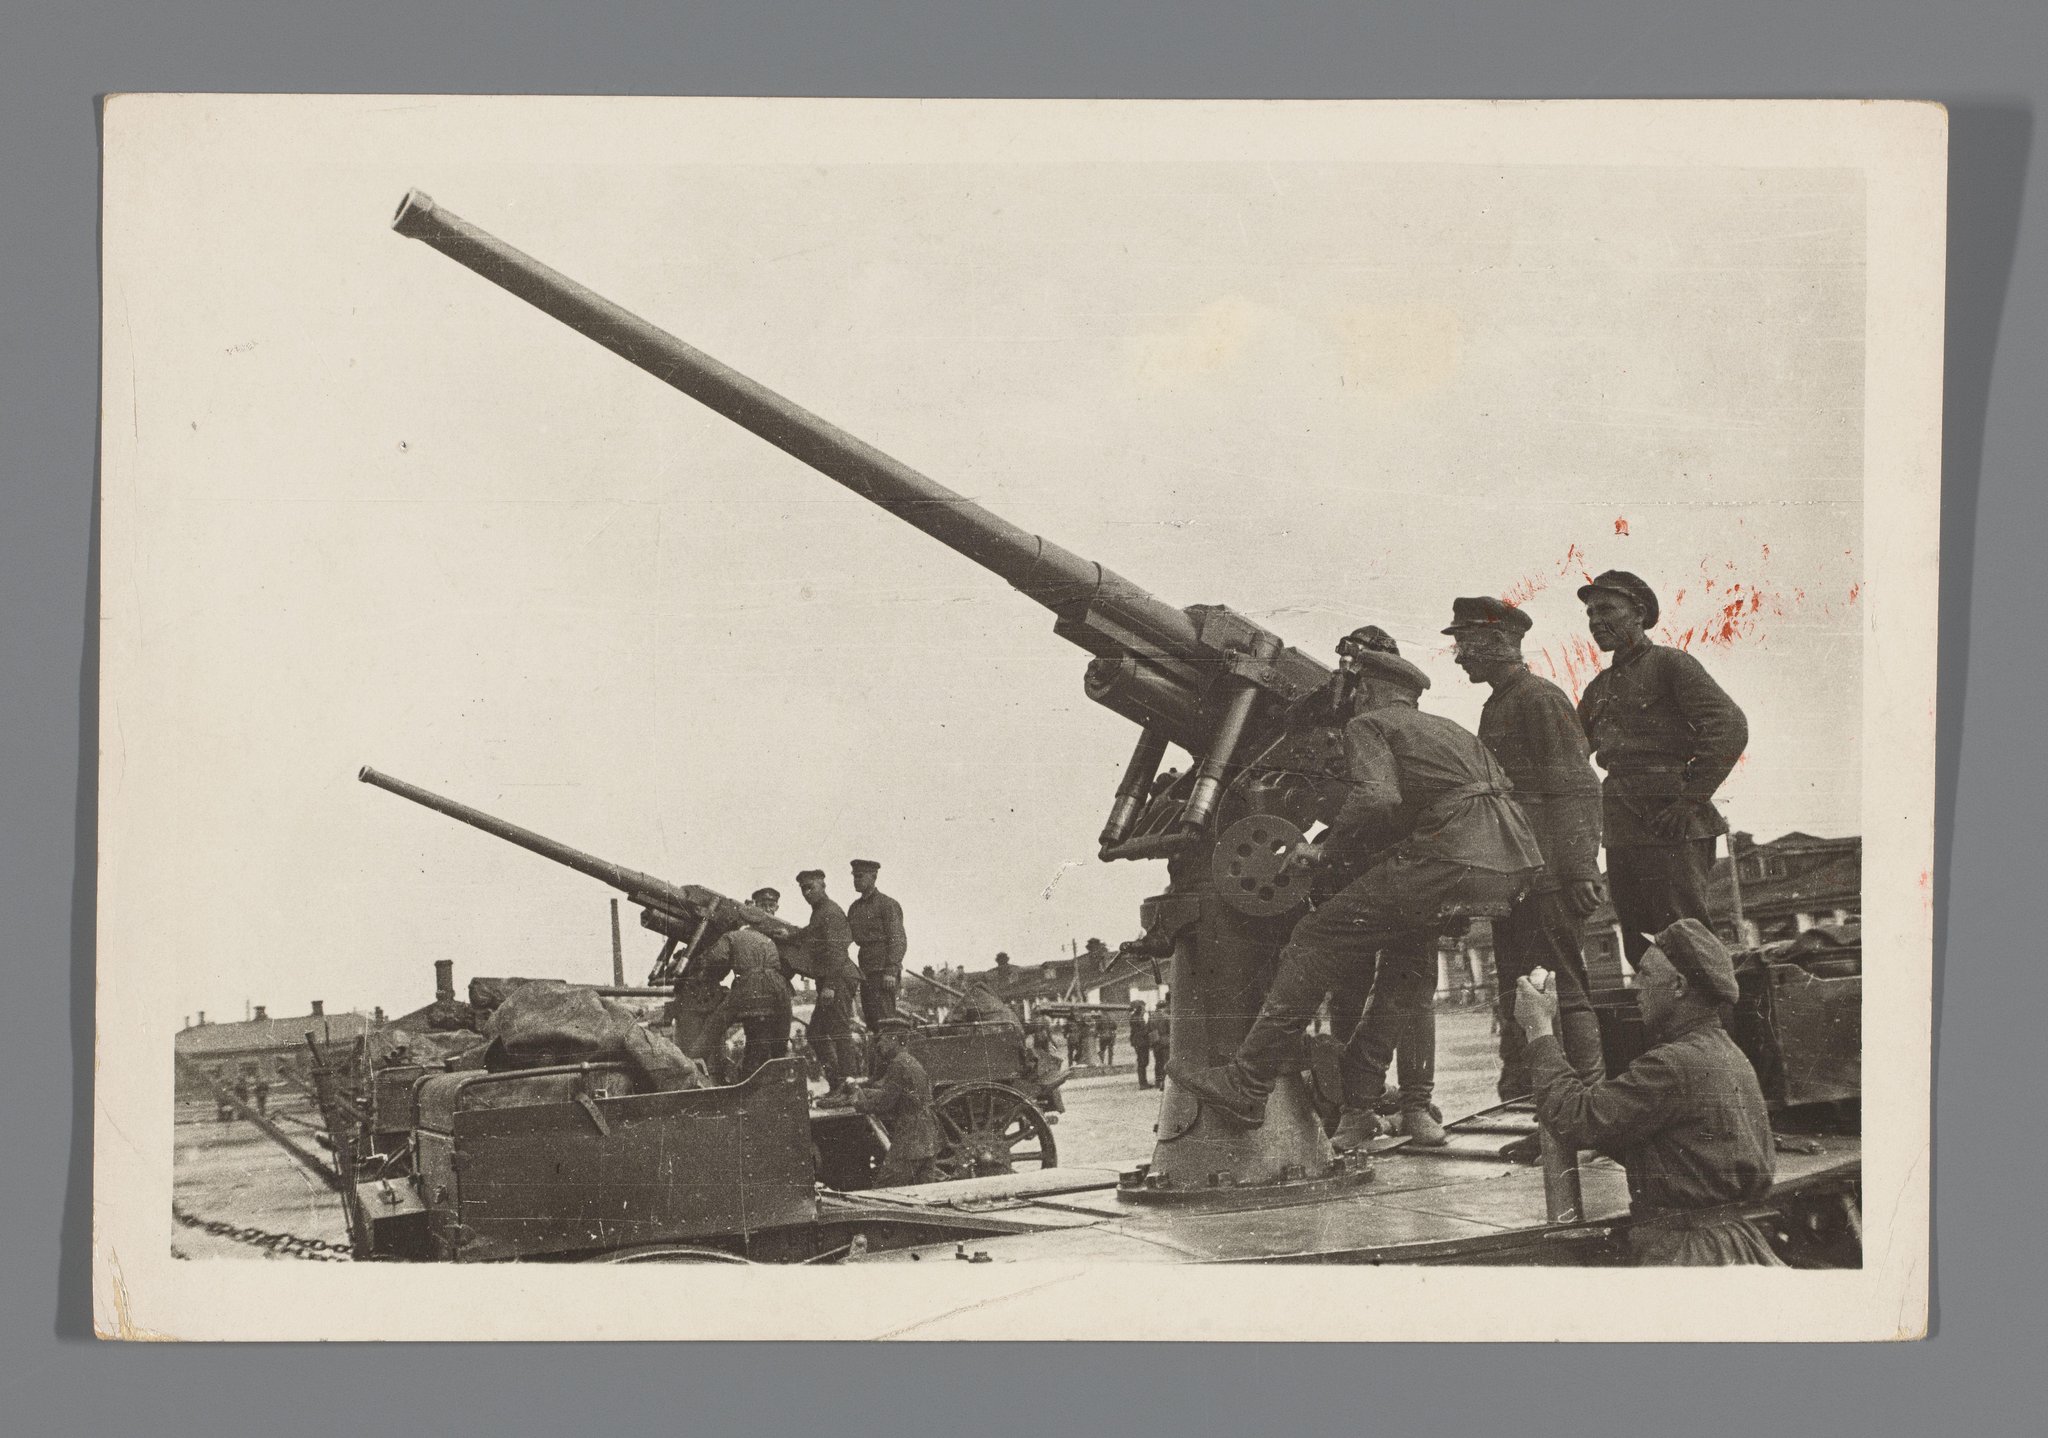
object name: photograph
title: Russisch anti-vliegtuig afweergeschut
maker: henri daniel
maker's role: fotograaf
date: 1930-1940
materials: photographic support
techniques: gelatin silver print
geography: united states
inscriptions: stamp: ‘HENRI DANIEL / PARIS […] / Copyright by / UNIONPHOTO […]’, ‘COPYRIGHT BY / UNIONBILD AMSTERDAM / […]’ en ‘COLLECTION COSSIRA’’